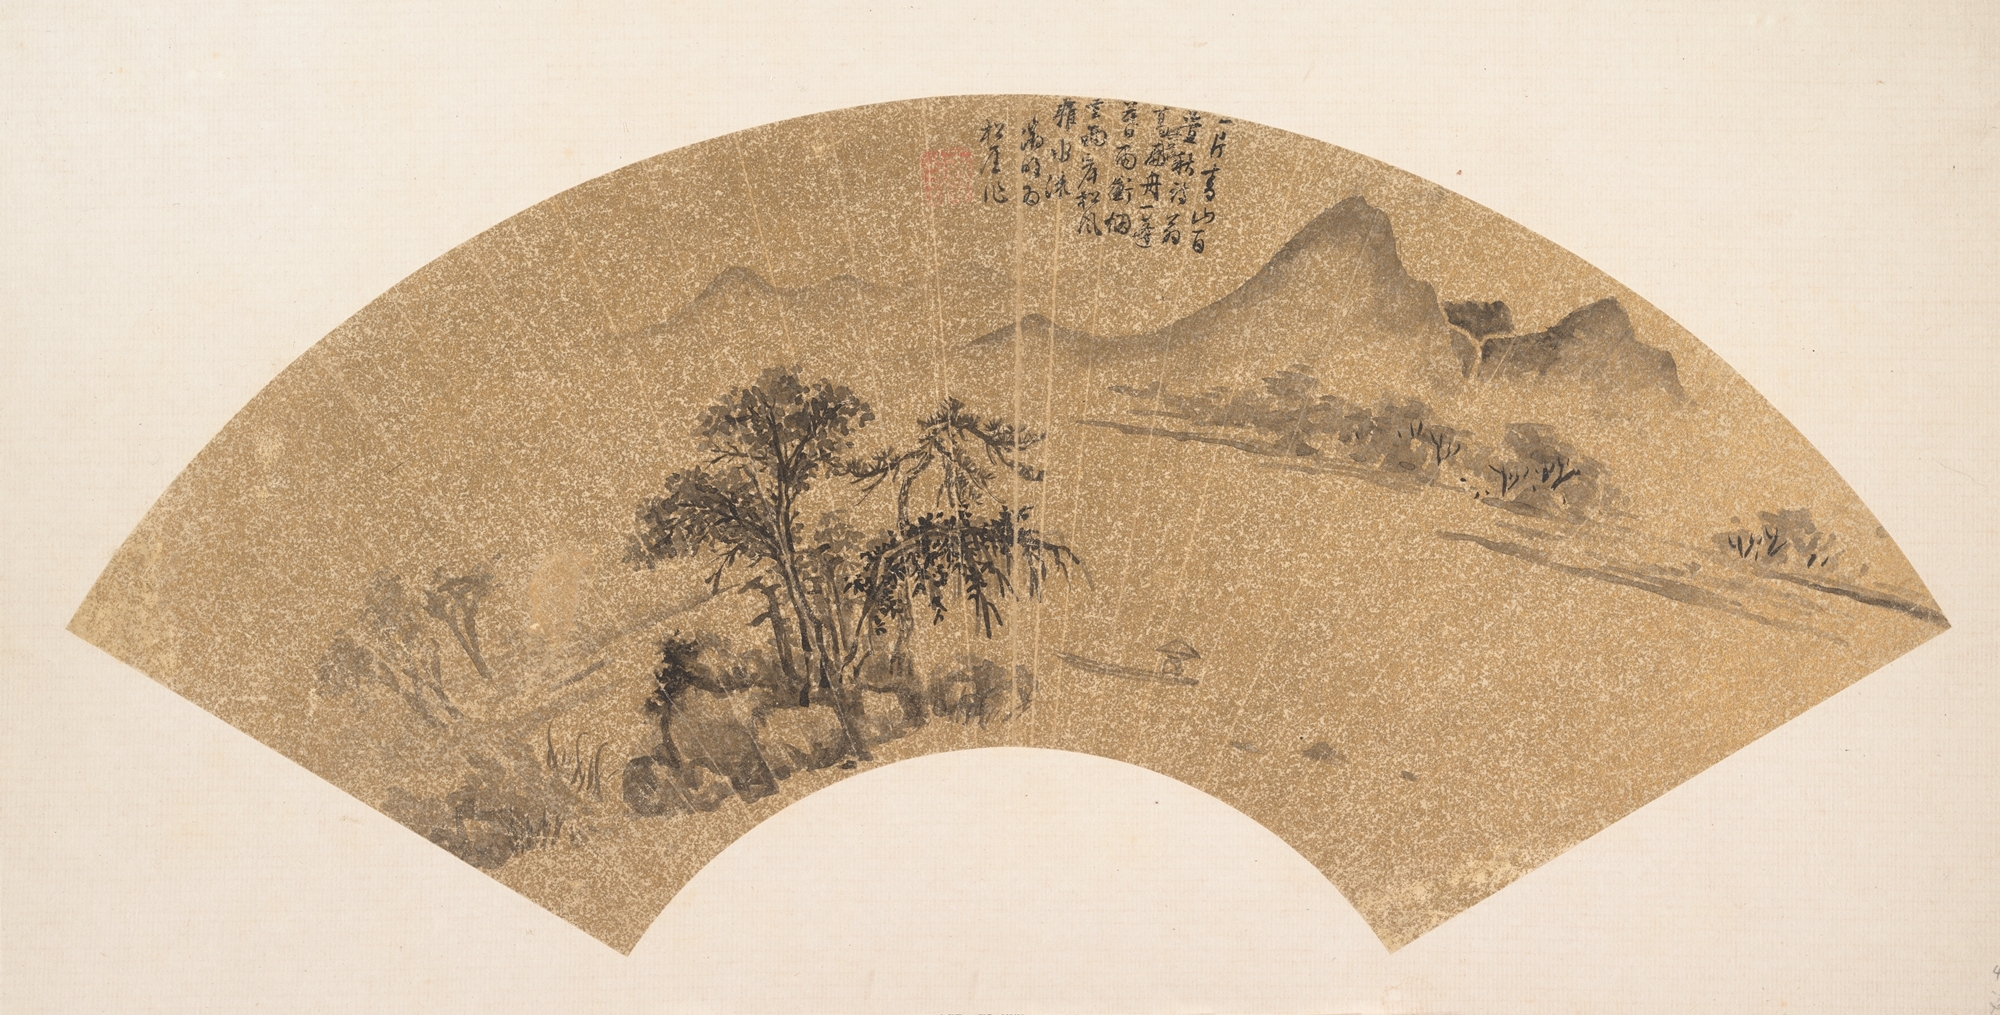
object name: folding fan mounted a an album leaf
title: Landscape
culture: chinese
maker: unidentified artist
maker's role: artist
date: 1368-1644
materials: gold, ink, paper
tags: mountains,landscapes